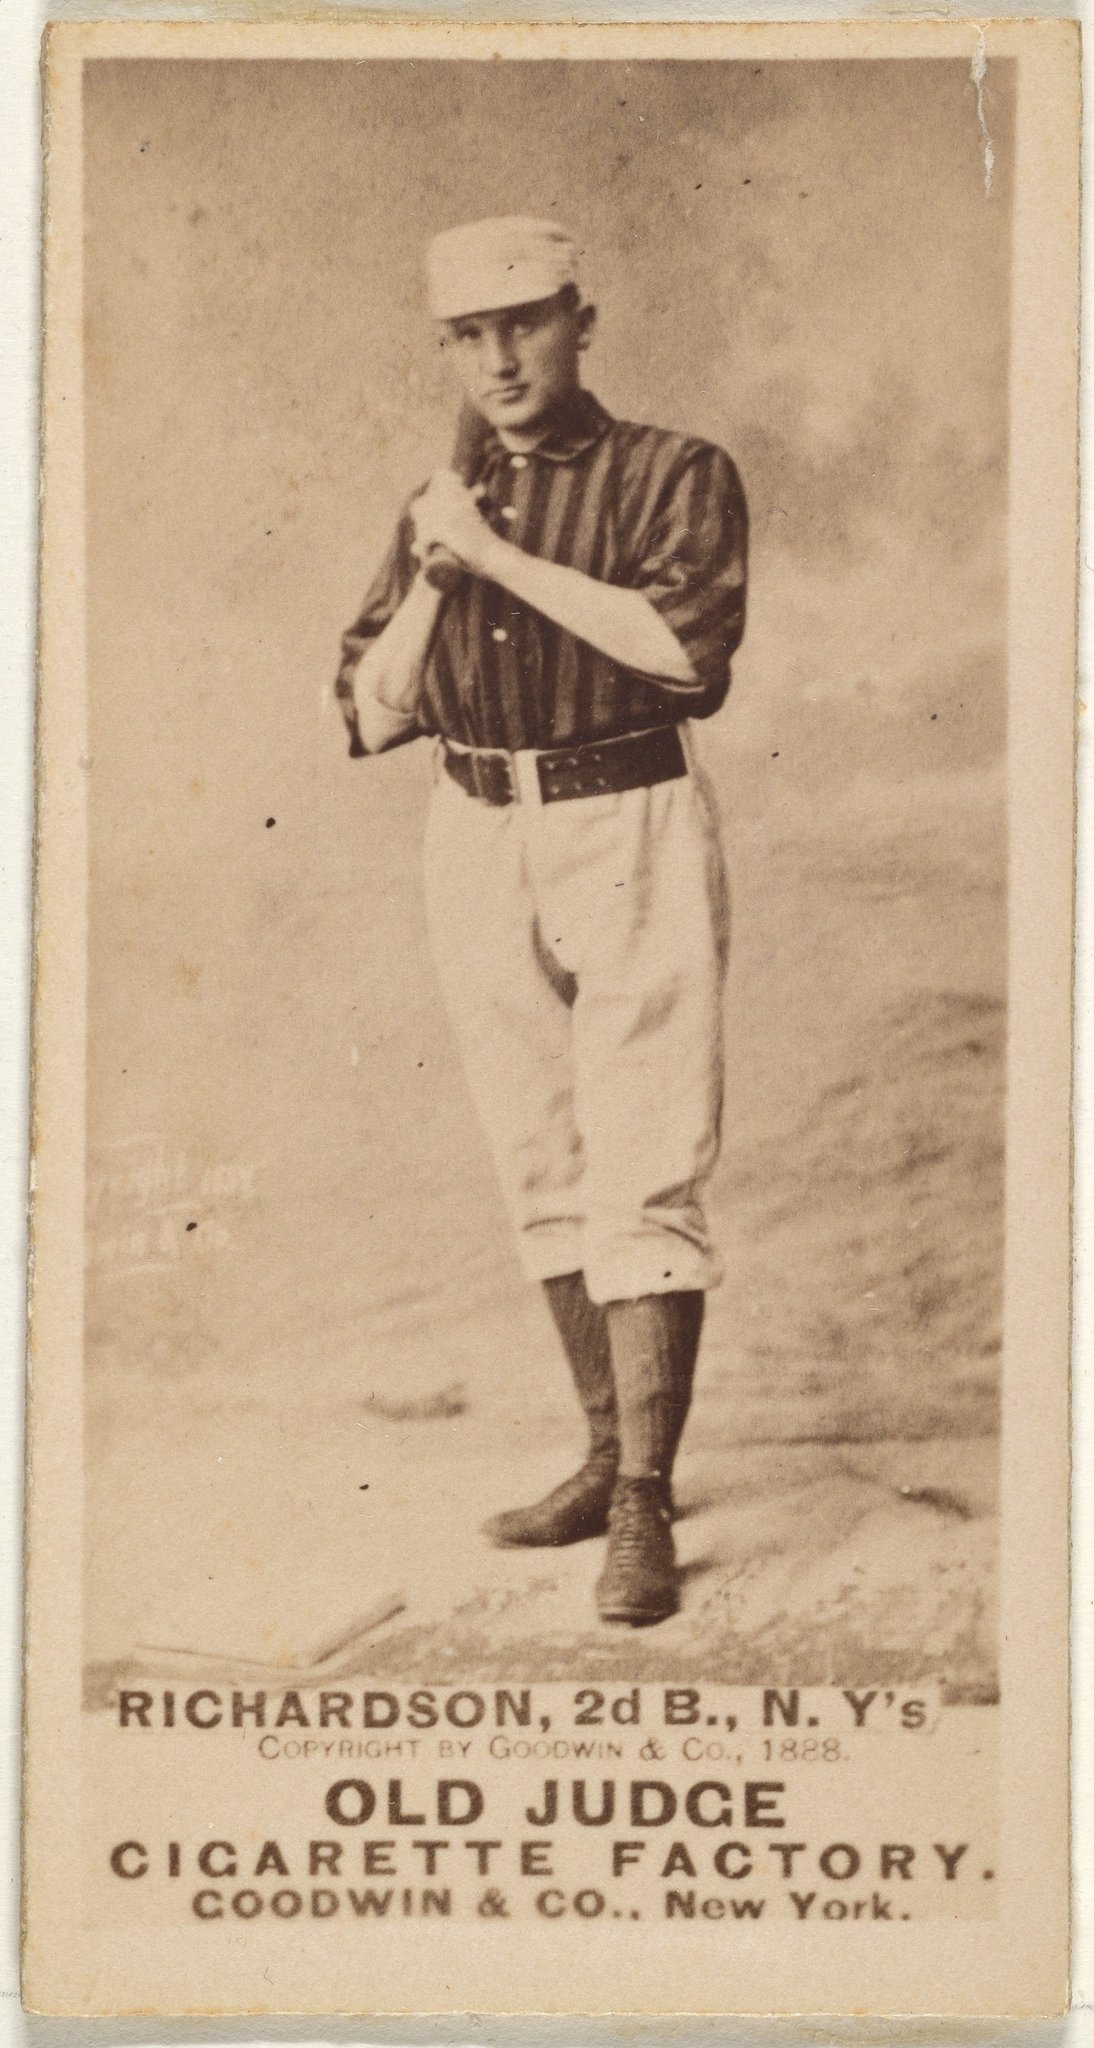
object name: baseball card, photograph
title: Danny Richardson, 2nd Base, New York, from the Old Judge series (N172) for Old Judge Cigarettes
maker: goodwin & company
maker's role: publisher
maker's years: 1850-1950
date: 1888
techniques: albumen silver print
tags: men,portraits,baseball,athletes